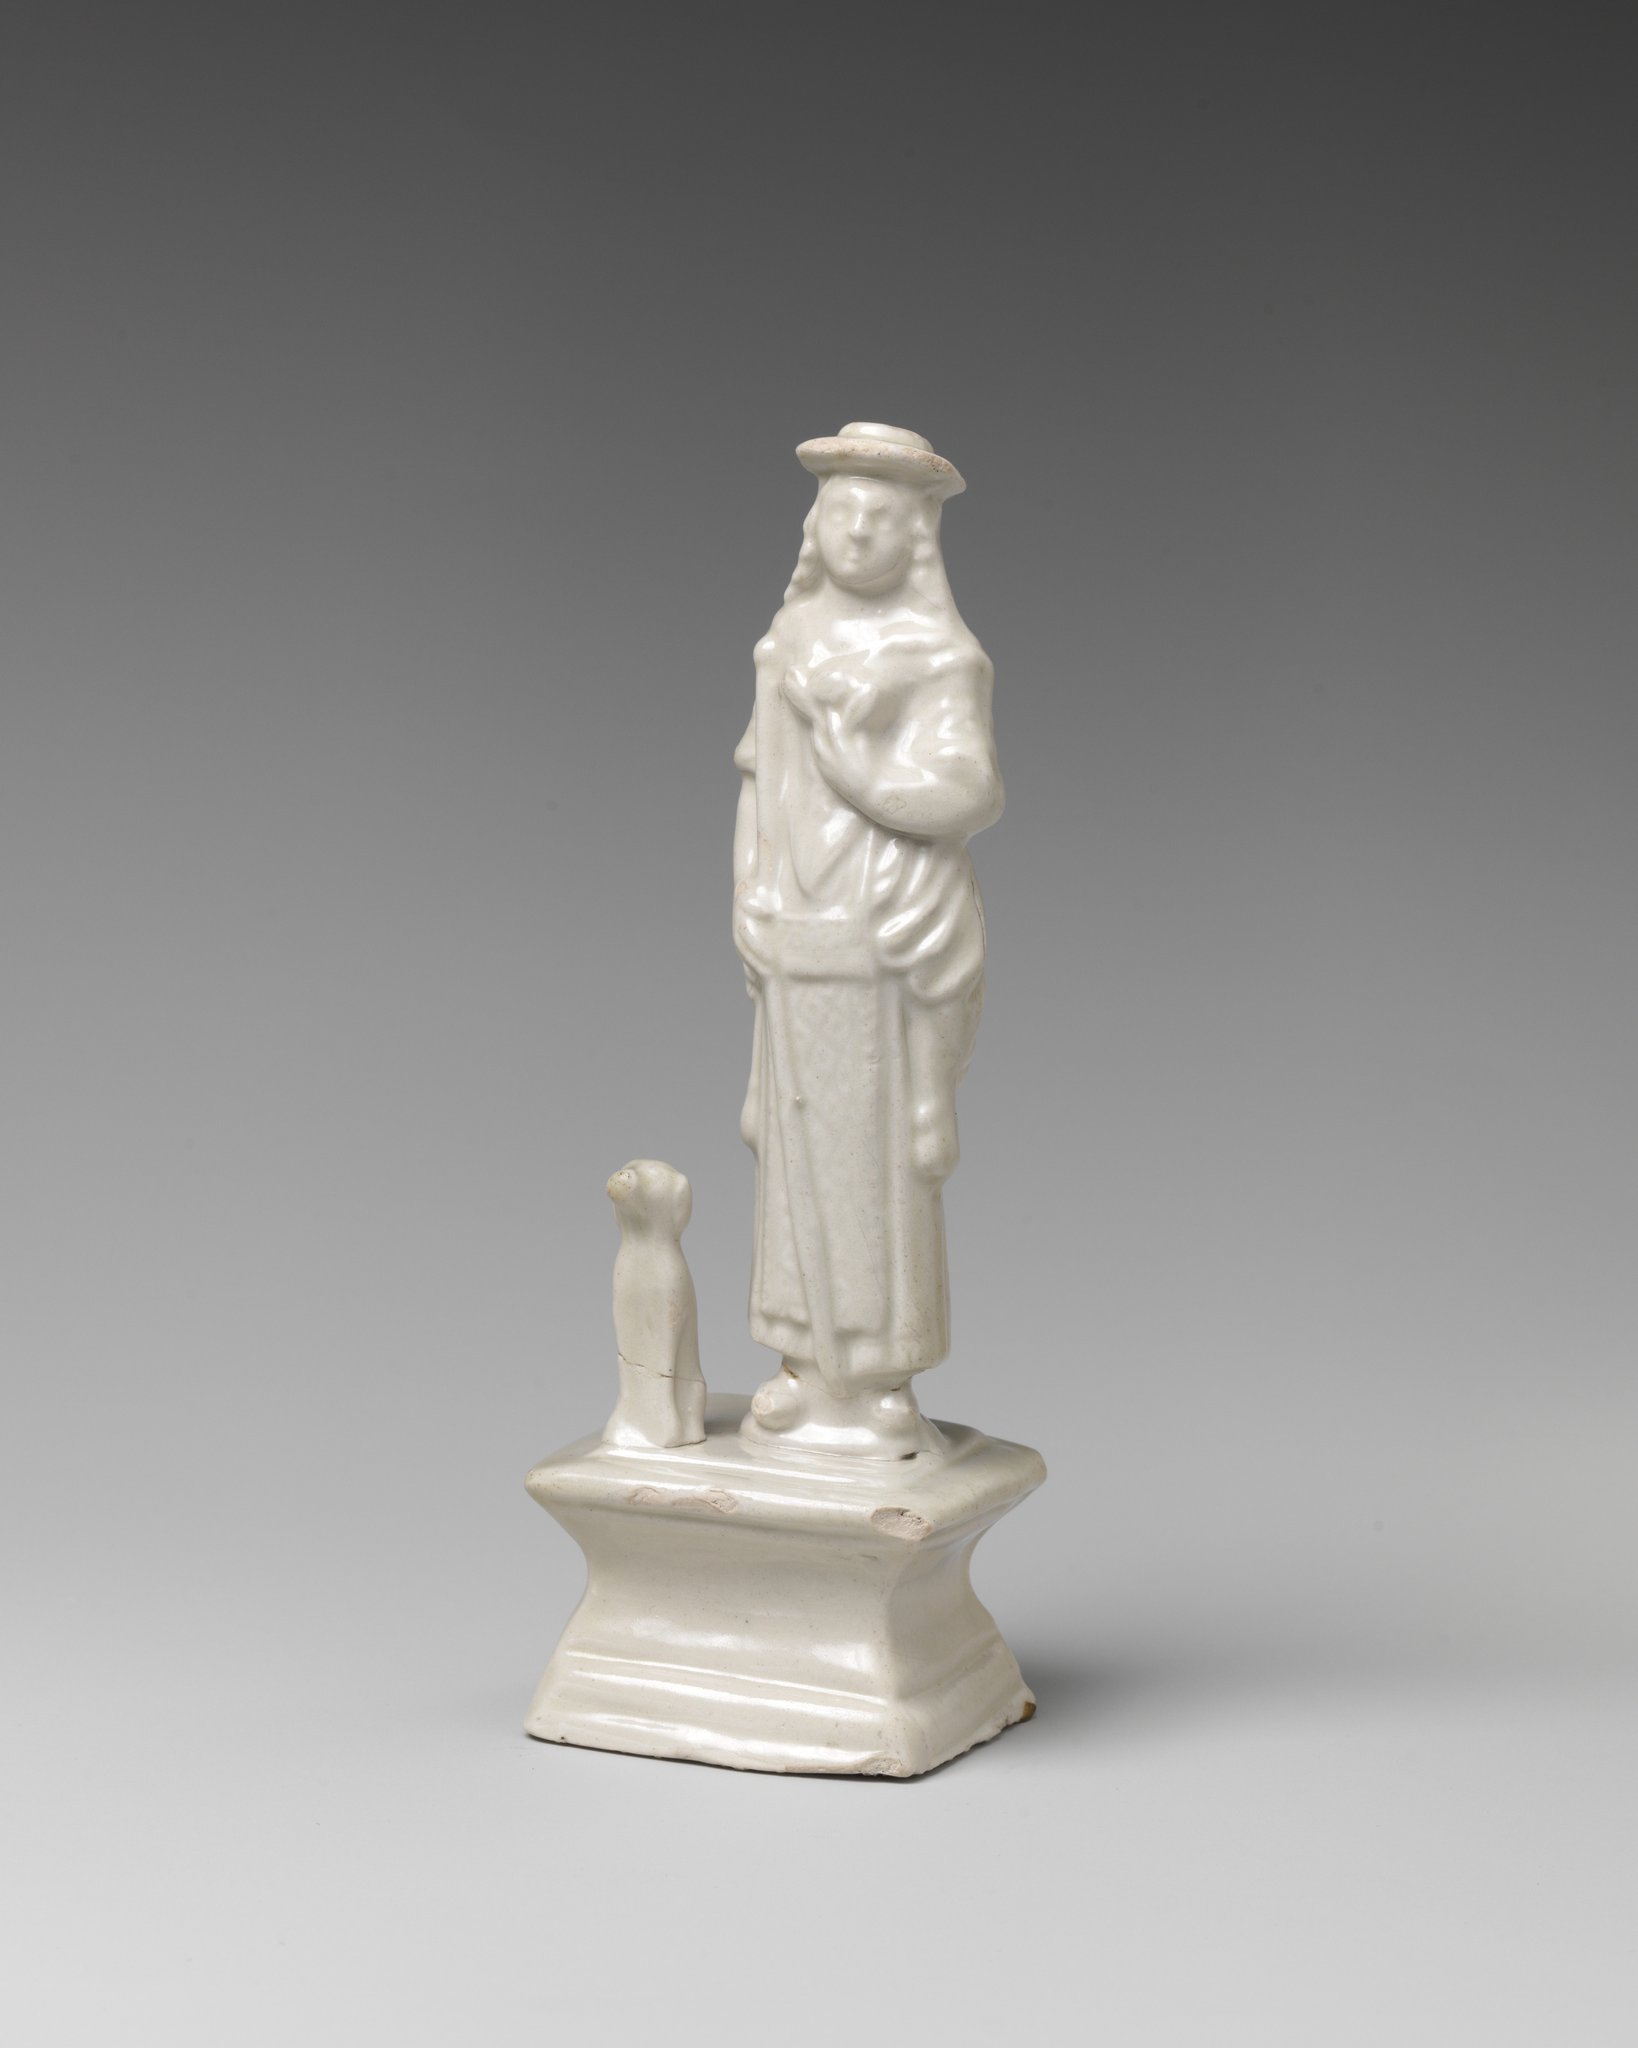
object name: figure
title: Lady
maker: thomas whieldon factory, stoke-on-trent, fenton vivian, staffordshire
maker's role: factory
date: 1745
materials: stoneware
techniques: salt glaze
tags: women